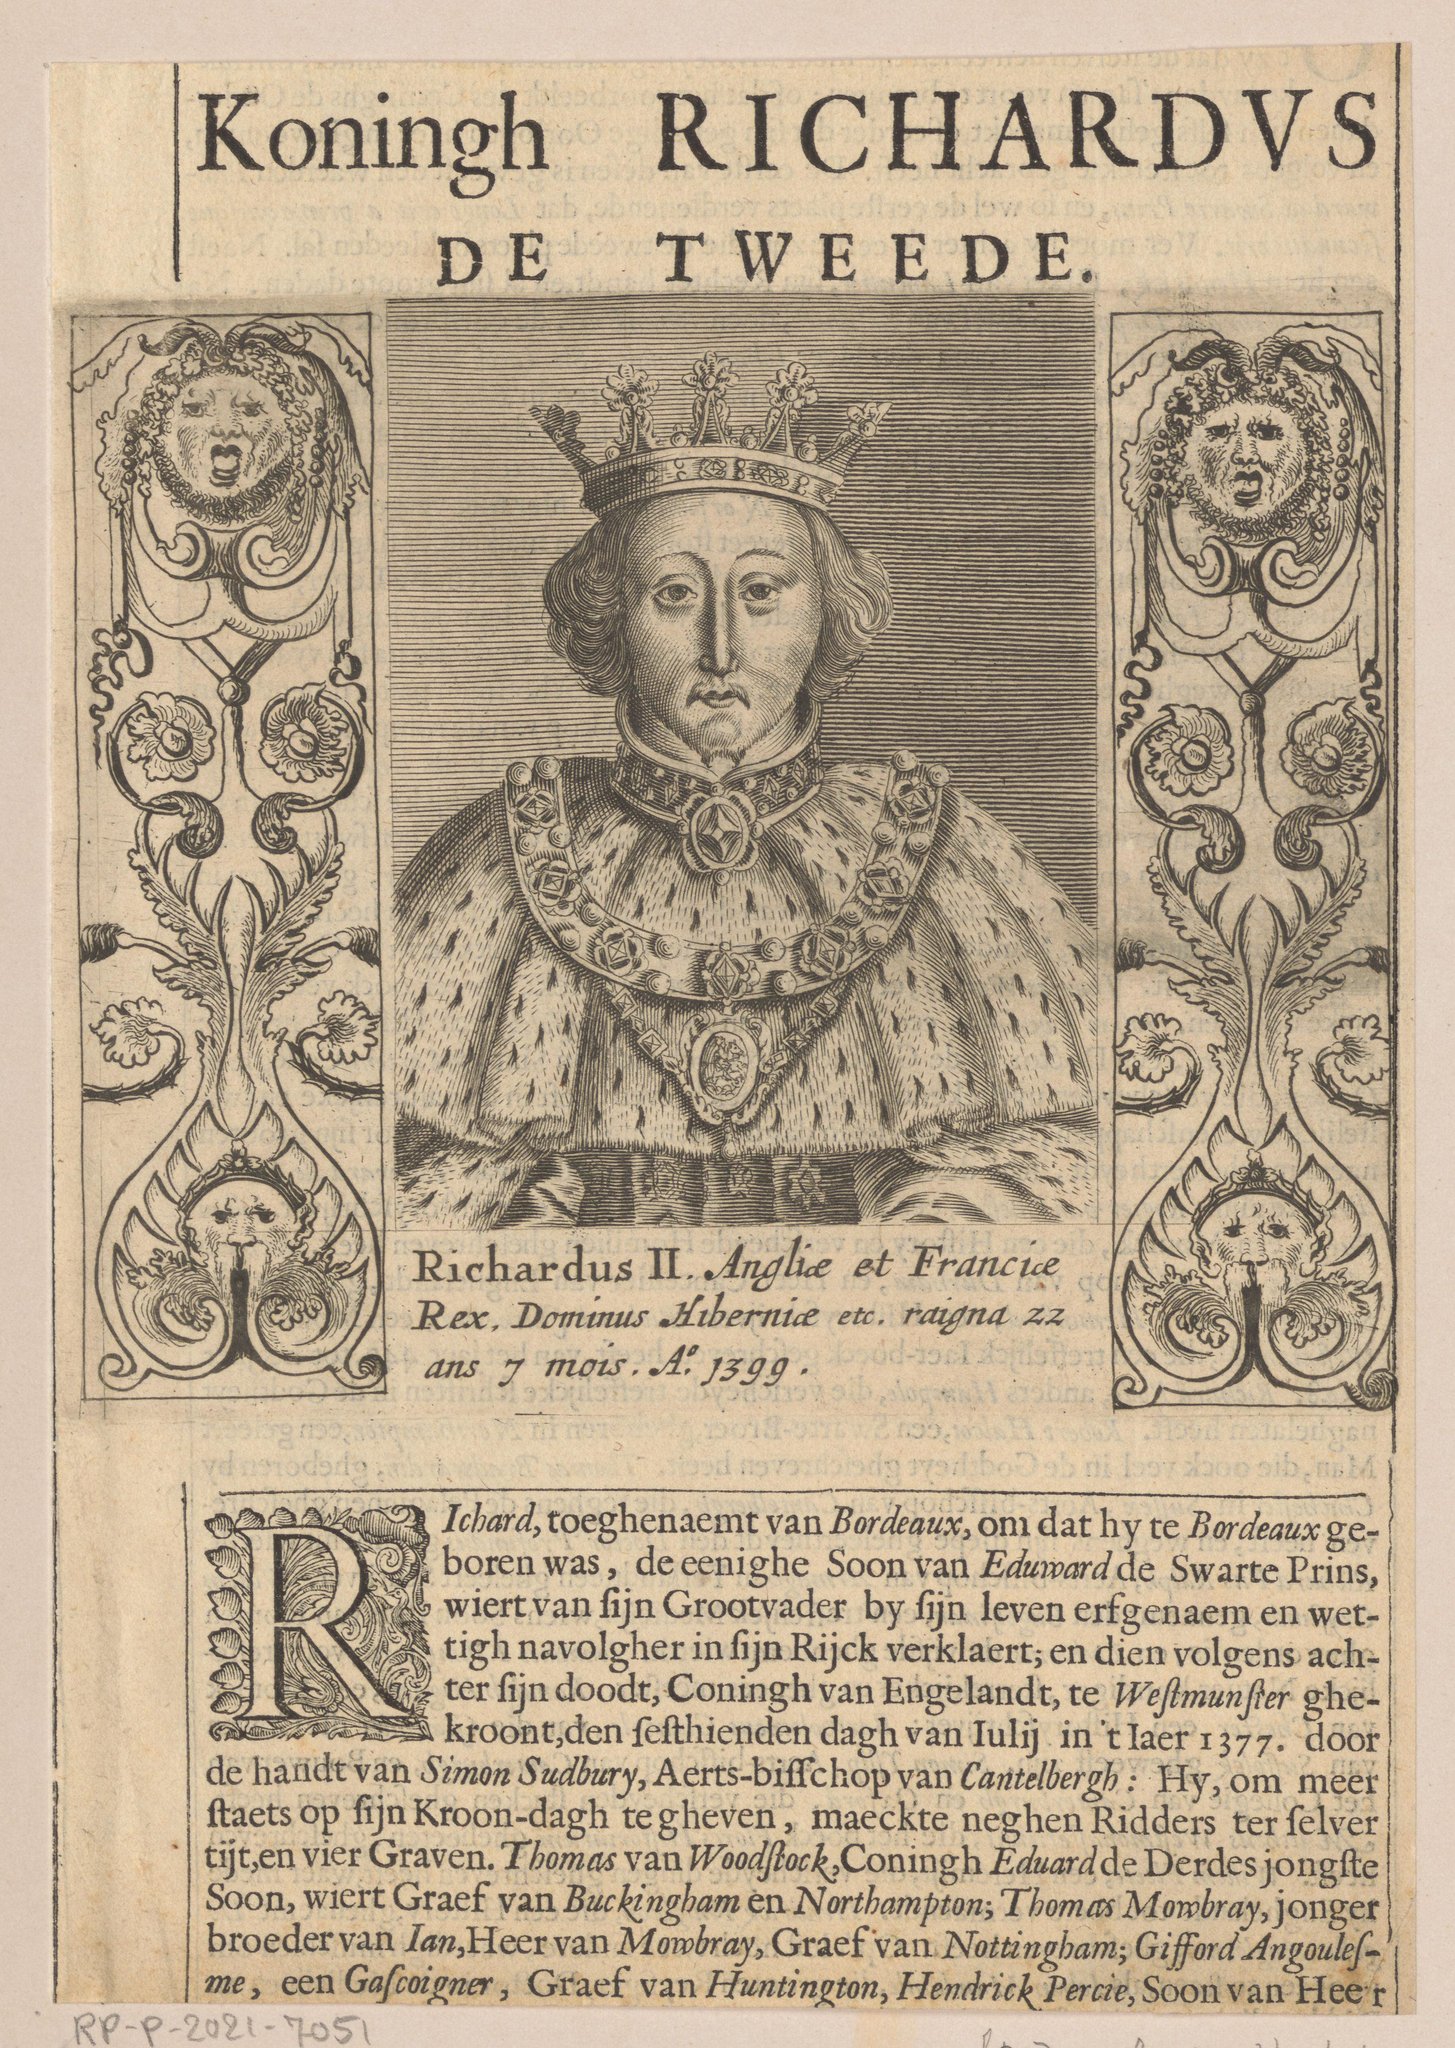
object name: book illustration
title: Portret van Richard II, koning van Engeland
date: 1649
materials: paper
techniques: engraving, letterpress printing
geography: amsterdam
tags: historical persons, king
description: Prent uit: Baker, Sir Richard. Cronyke van het leven en bedryff van alle de coningen van Engeland (...). Amsterdam: Cornelis Danckerts, 1649, dl. 1, p. 130.